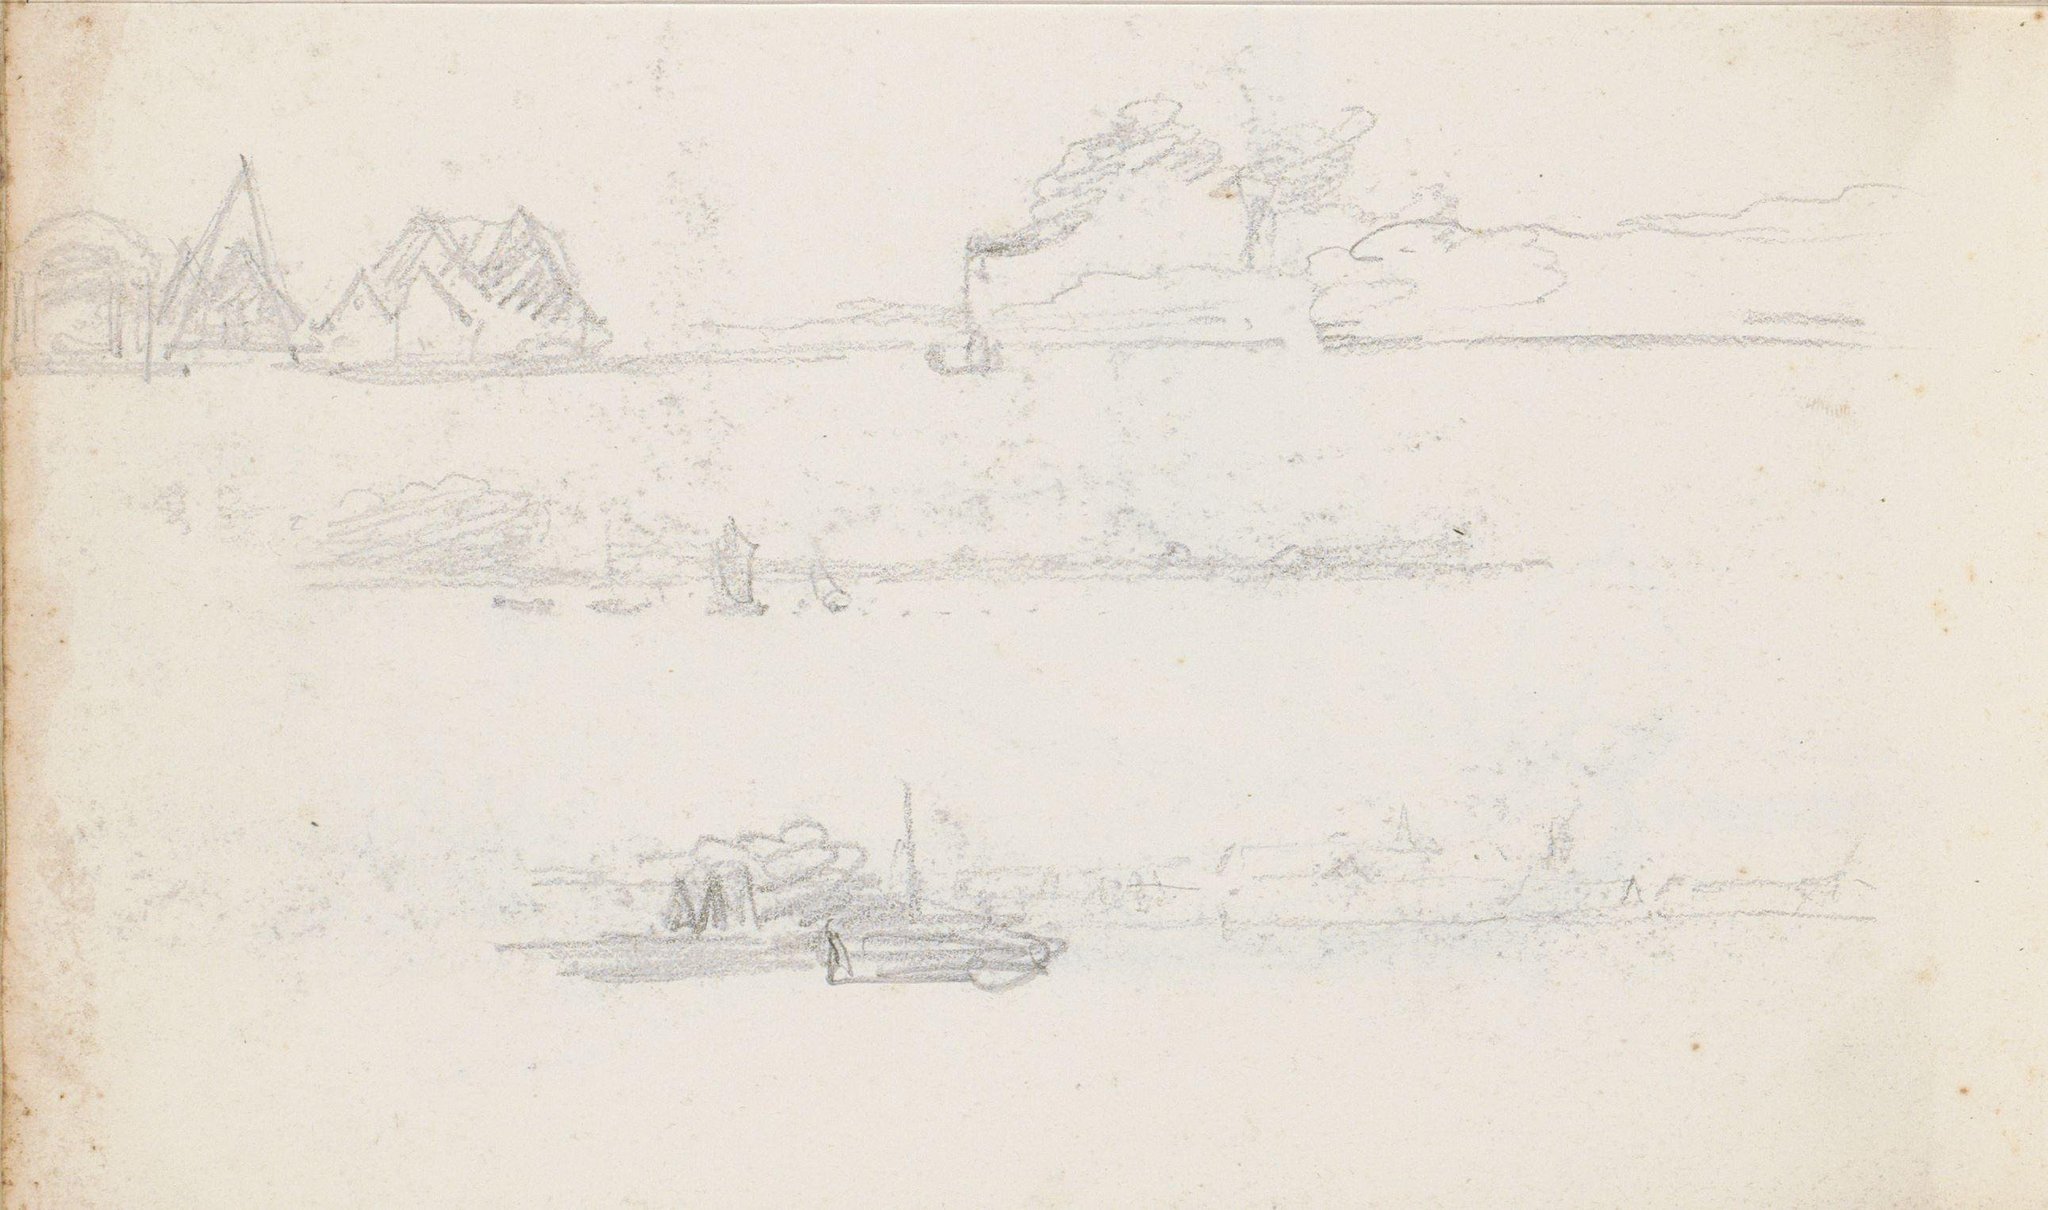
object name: sketchbook leaf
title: Landschappen met water en boten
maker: petrus johannes schotel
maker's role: draughtsman, painter, print maker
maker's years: 1808-1865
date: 1841-1865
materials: paper, pencil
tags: landscapes with waters, waterscapes, seascapes (in the temperate zone)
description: Pagina 40 uit een schetsboek met 80 pagina's.